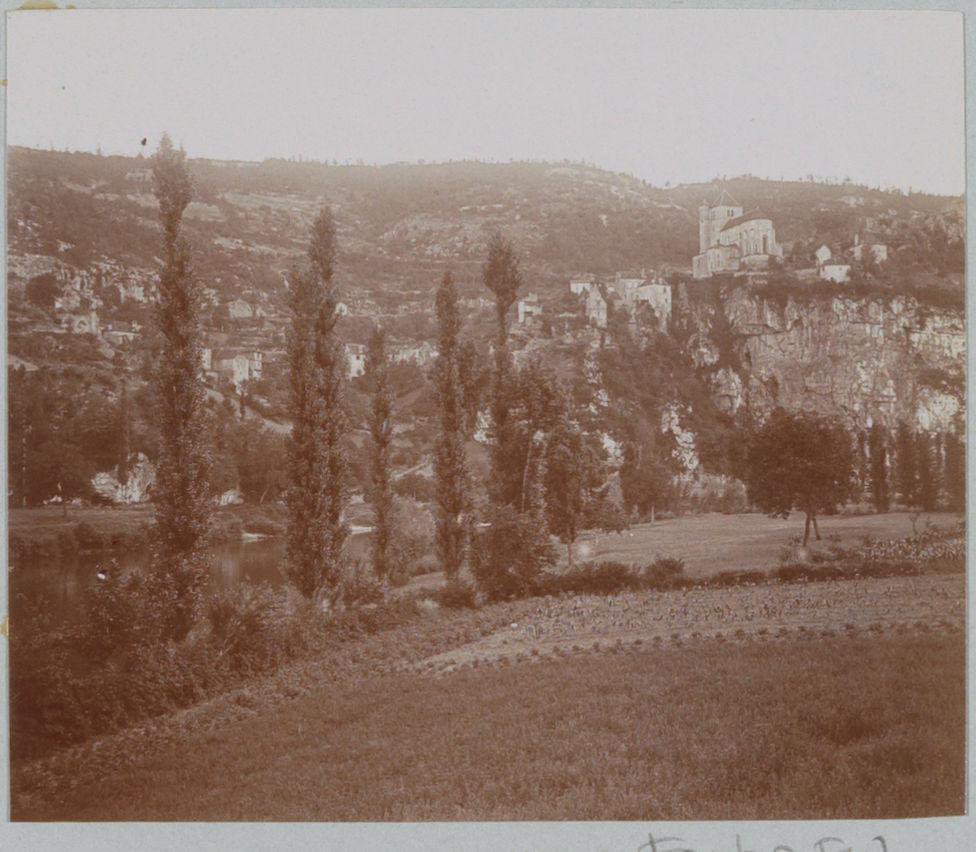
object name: photograph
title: Bergachtig landschap in Frankrijk met velden en een kerk op een rots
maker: Anonymous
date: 1905-1910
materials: paper, photographic support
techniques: gelatin silver print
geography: france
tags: field filled with a crop, church (exterior), mountains, france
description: Onderdeel van Fotoalbum van een Franse amateurfotograaf met bezienswaardigheden in Frankrijk, Zwitserland en Italië.